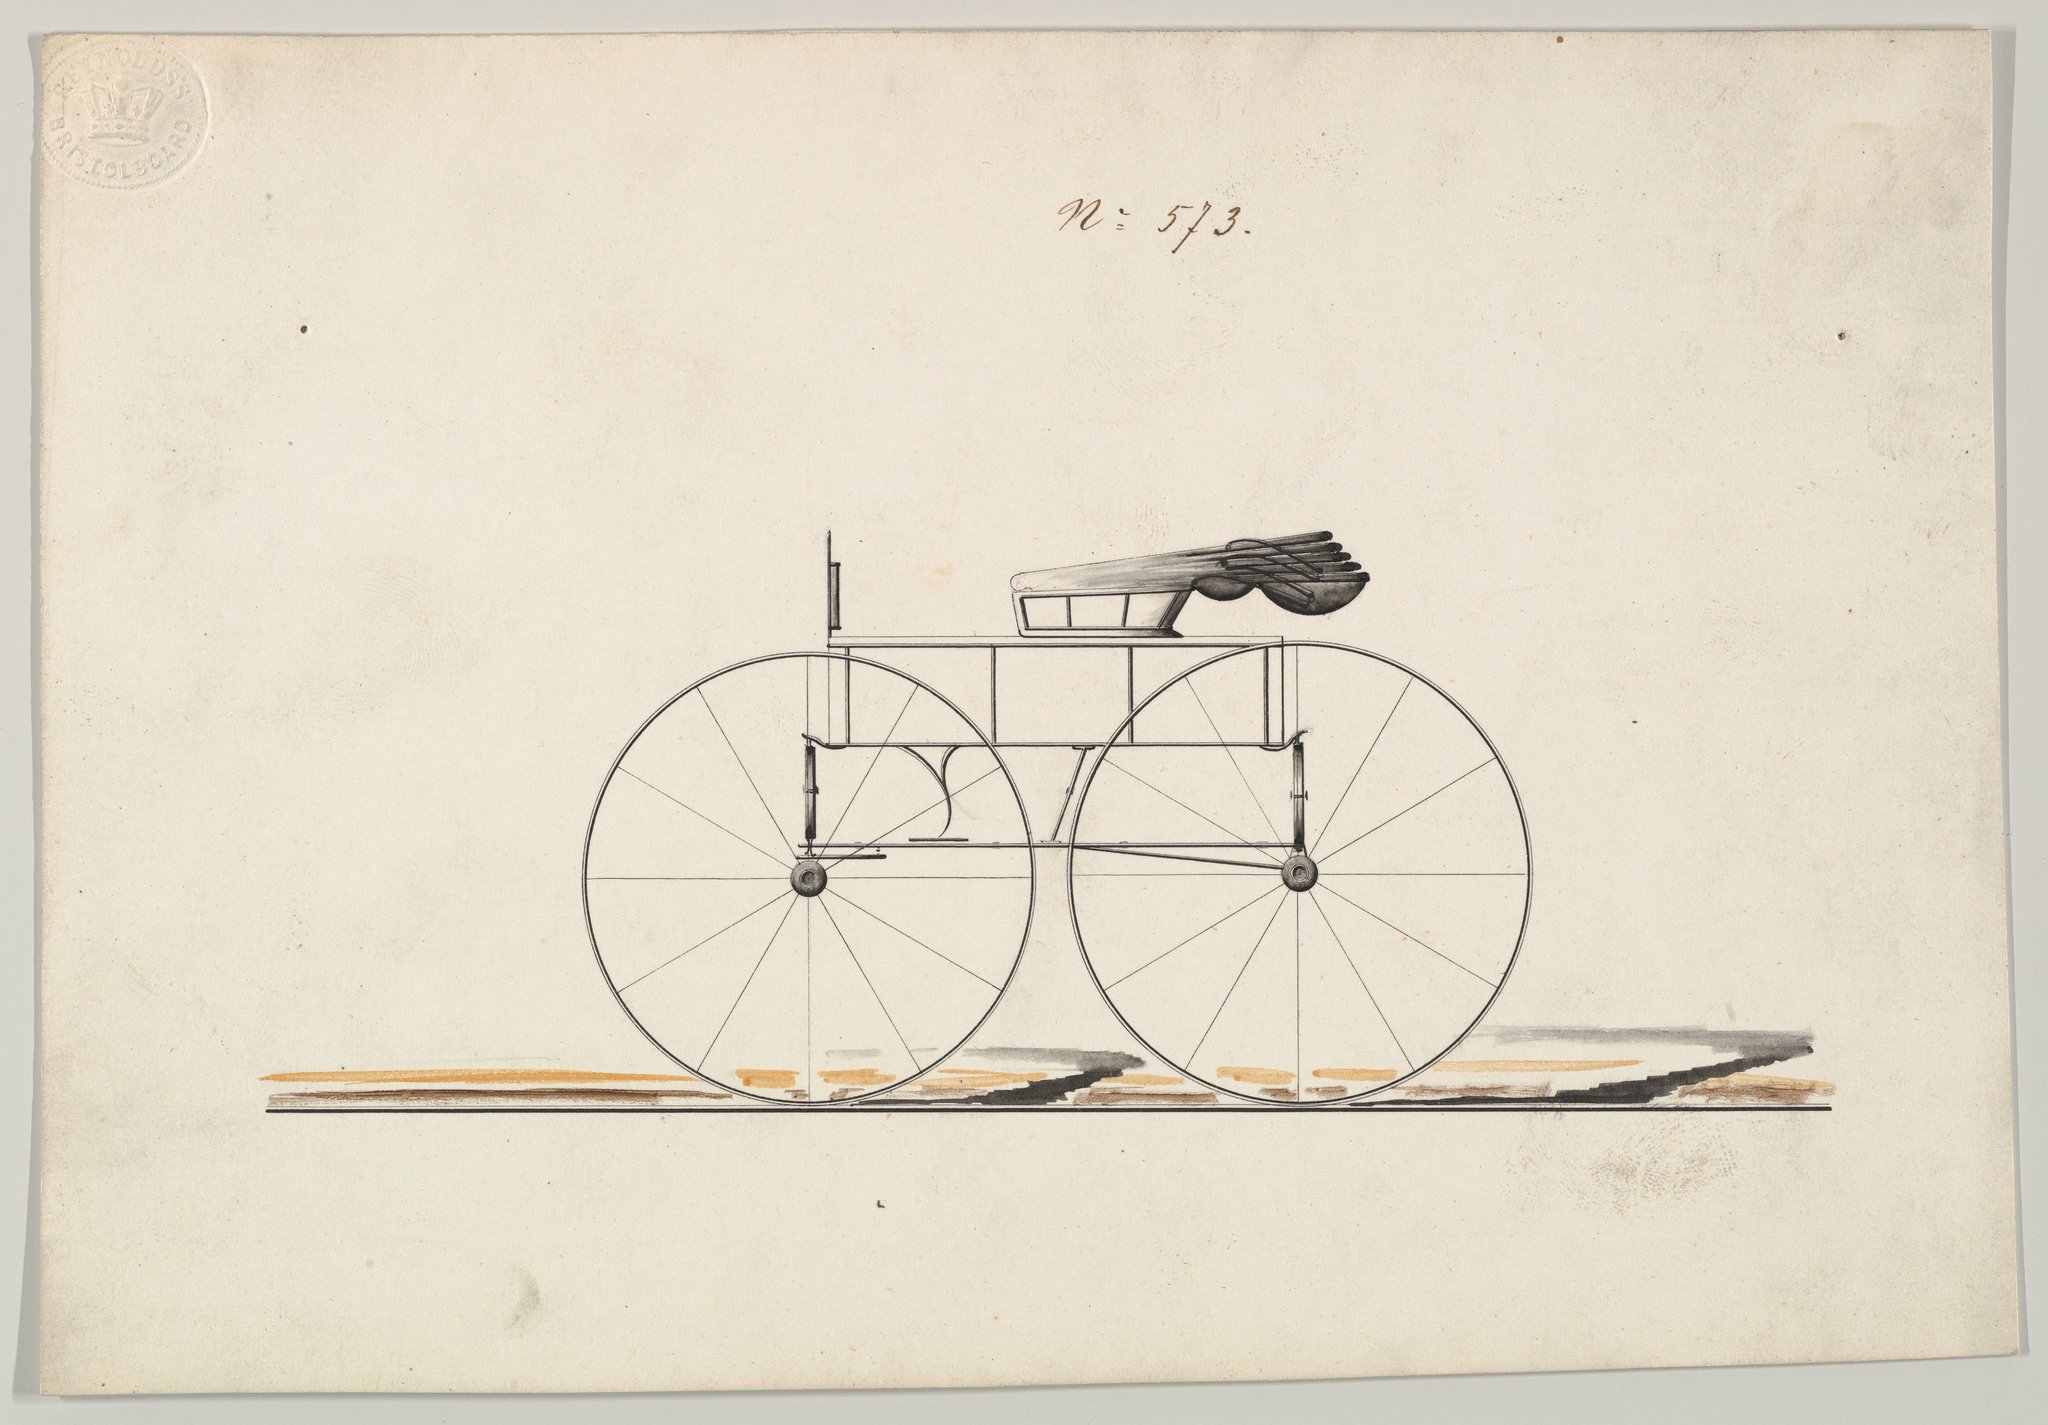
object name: drawing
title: Box Wagon #573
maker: brewster & co.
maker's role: manufacturer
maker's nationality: american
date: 1865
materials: gouache, ink, watercolor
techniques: pen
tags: carriages